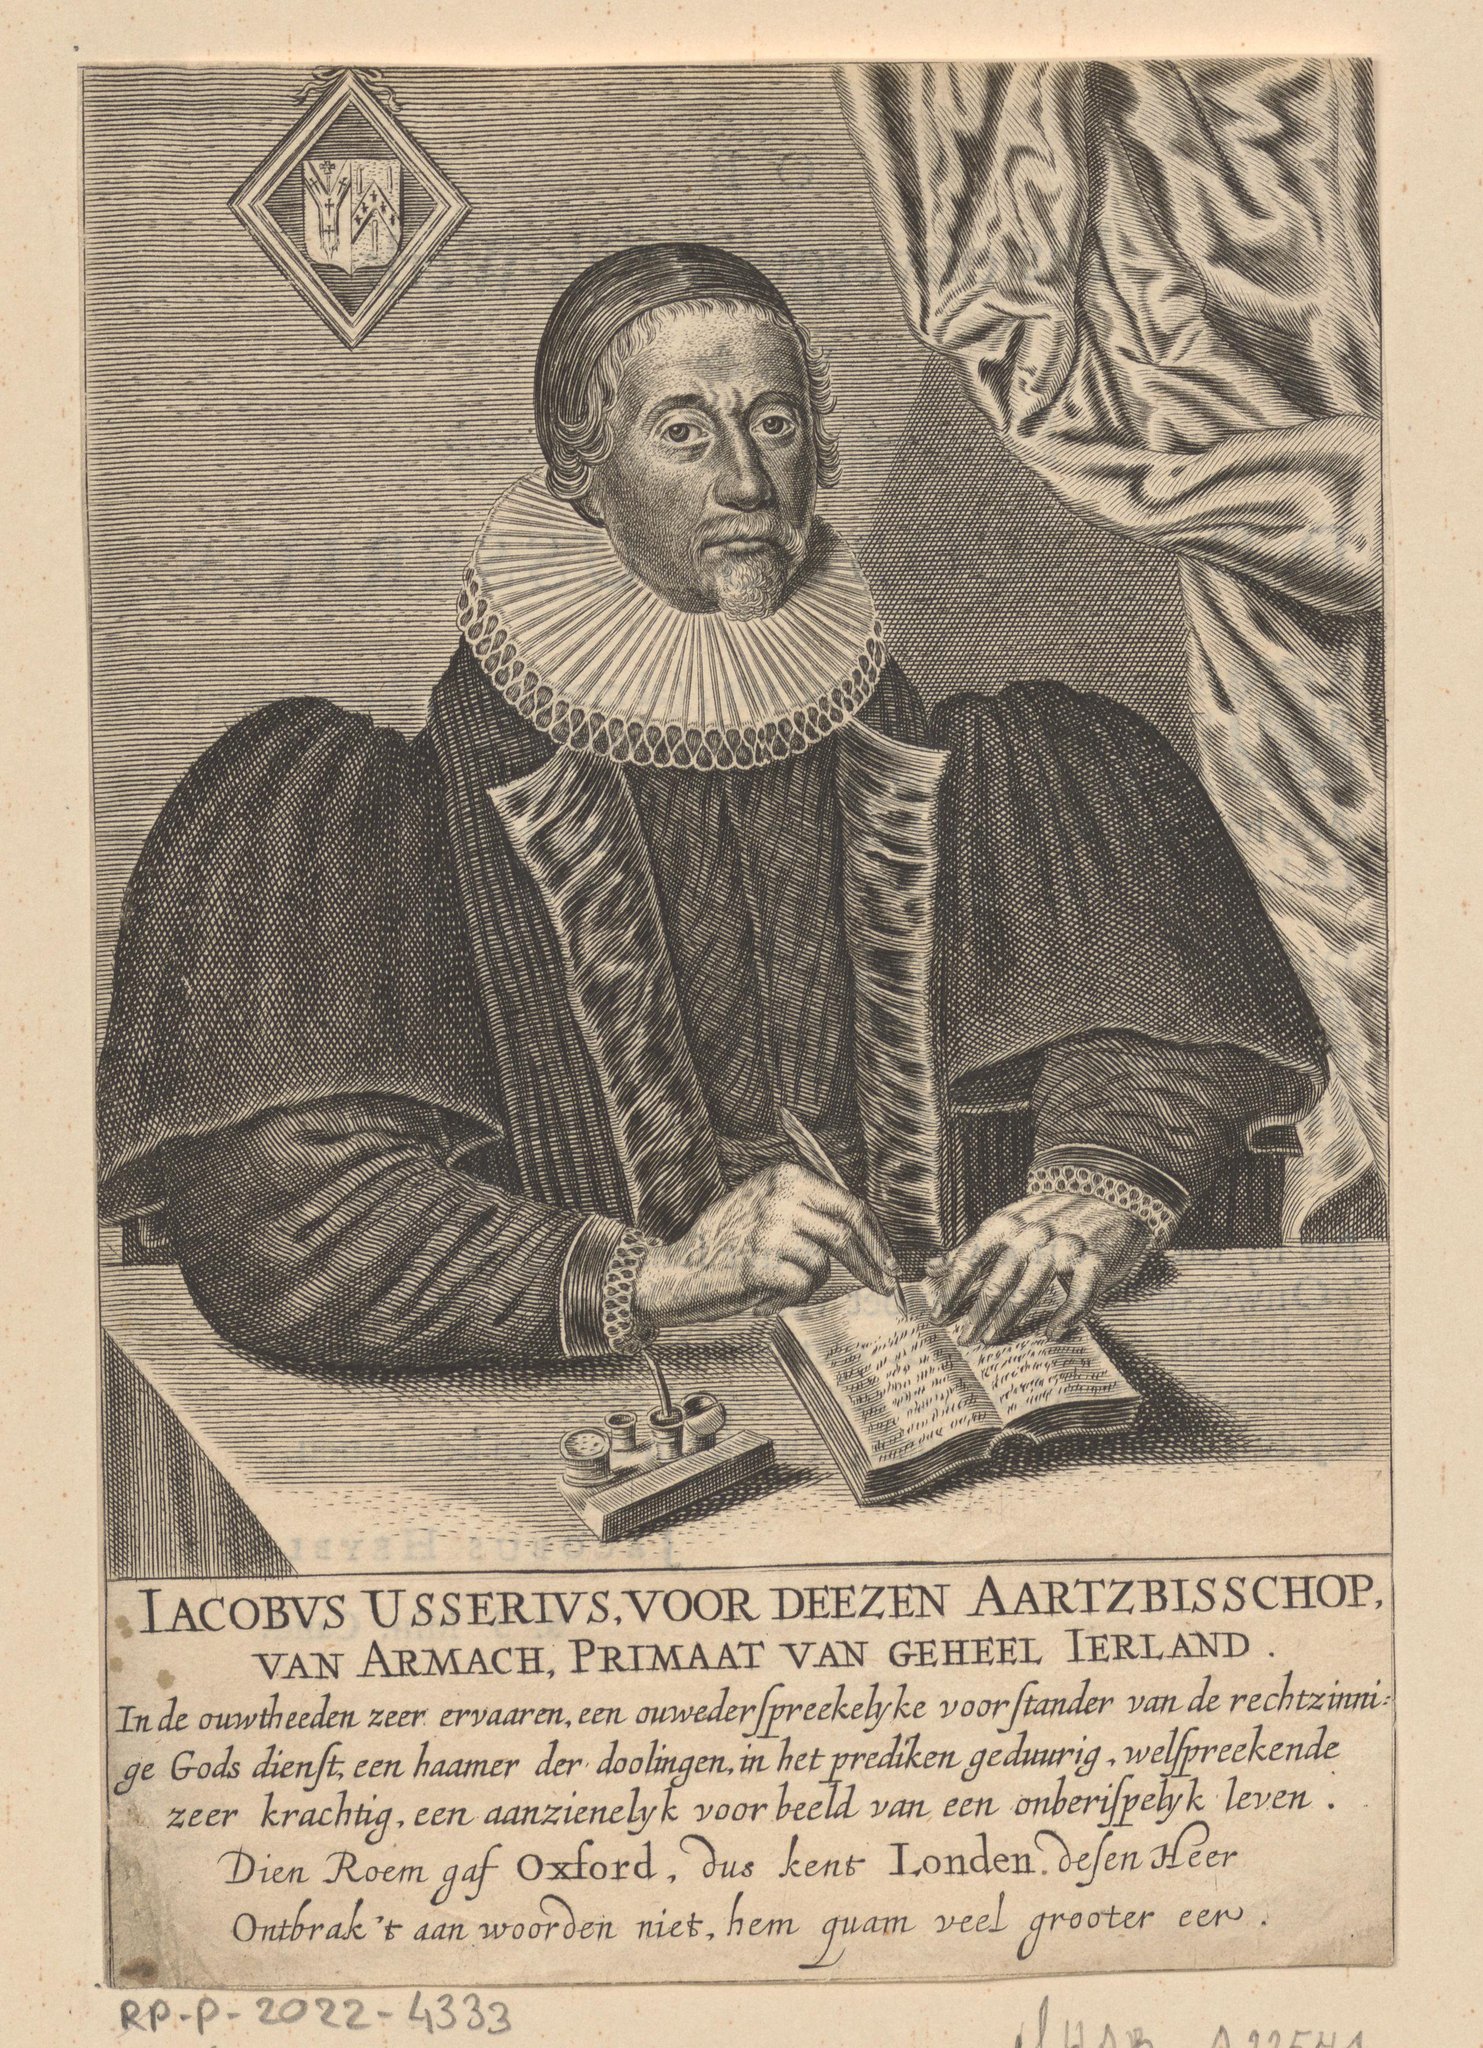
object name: print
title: Portret van James Ussher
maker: Anonymous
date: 1634-1680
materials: paper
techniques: engraving, etching, letterpress printing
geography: northern netherlands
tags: archbishop, bishop, etc. (roman catholic), historical persons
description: Prent komt uit een onbekende uitgave, mogelijk een Nederlandse vertaling van het werk van James Ussher door Jacobus Heyblocq.